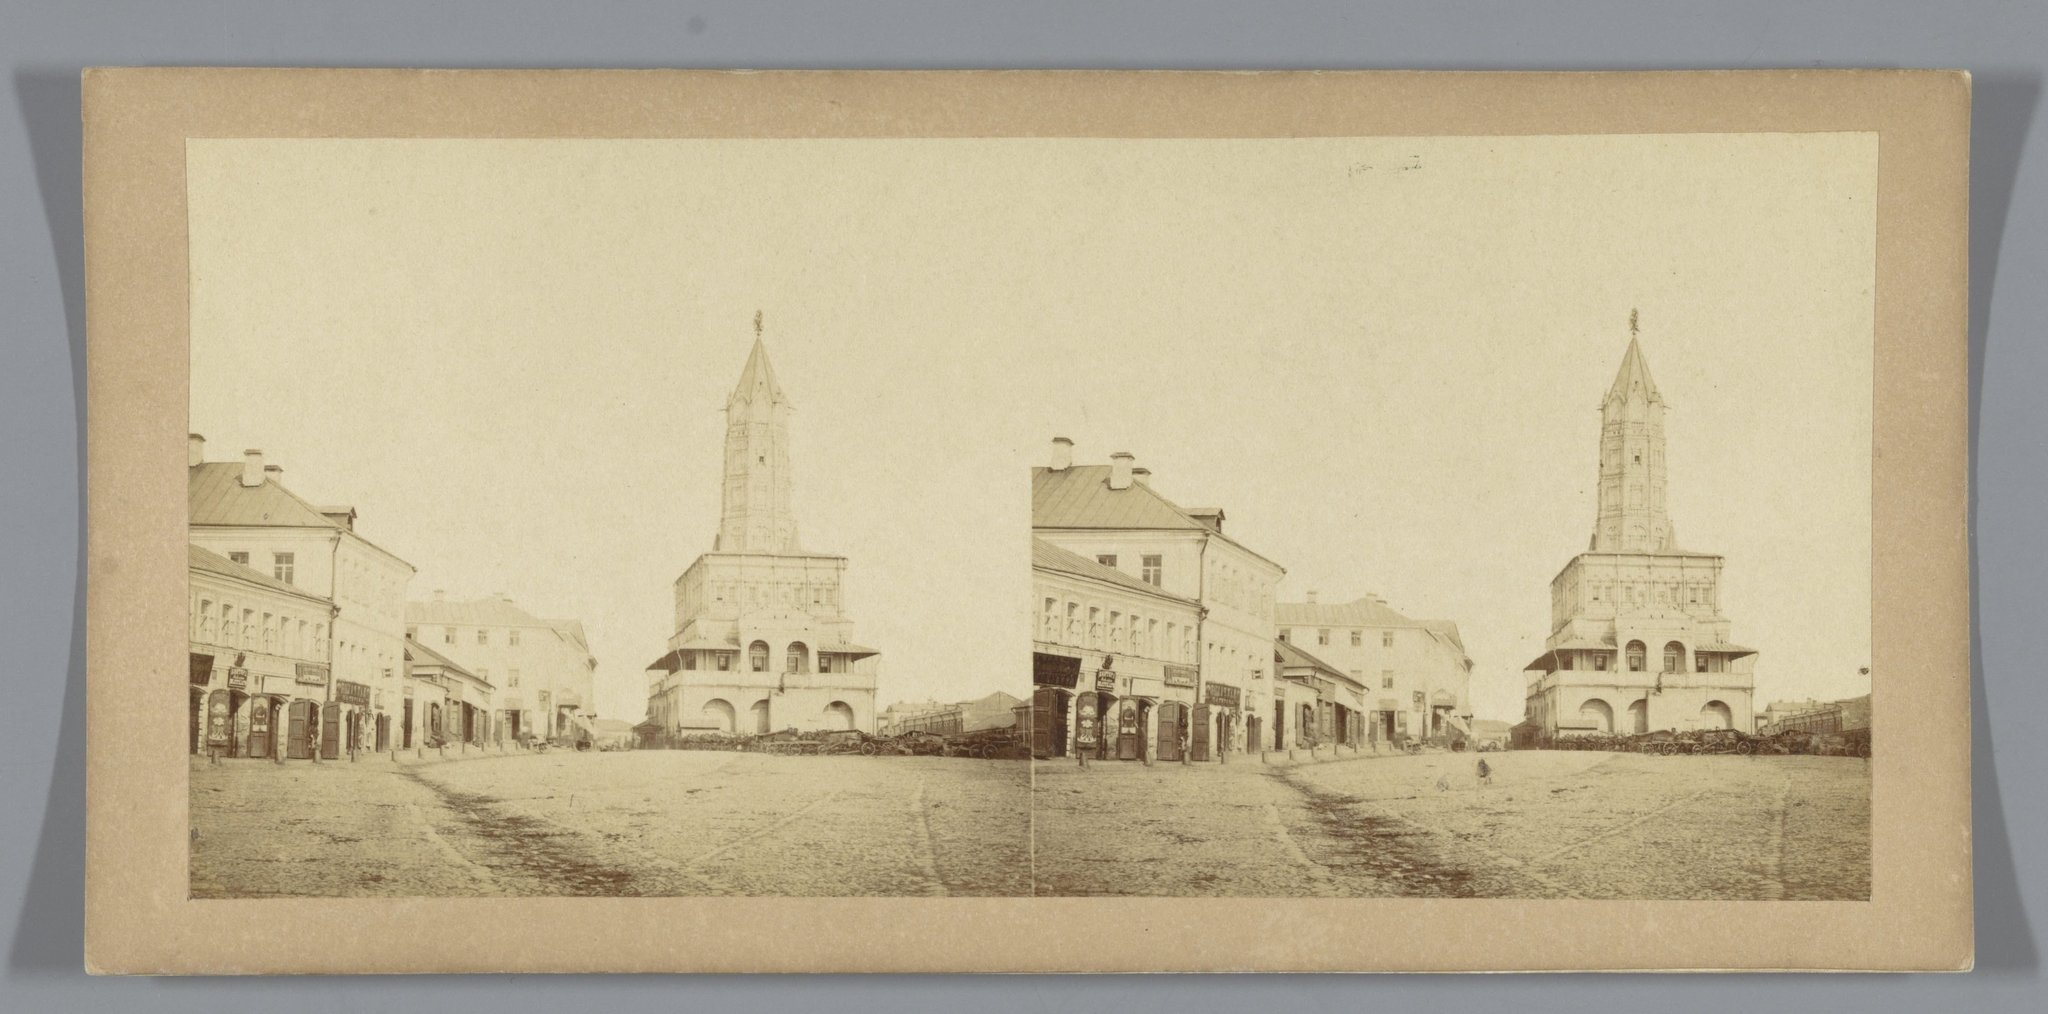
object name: stereograph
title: Gezicht op een watertoren, vermoedelijk in Moskou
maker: Anonymous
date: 1850-1880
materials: cardboard, photographic support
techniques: albumen print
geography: moscow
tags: water tower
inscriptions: inscription: ‘Reservoir d'eau au faubourg à Moscou’, inscription: ‘D. 10.’